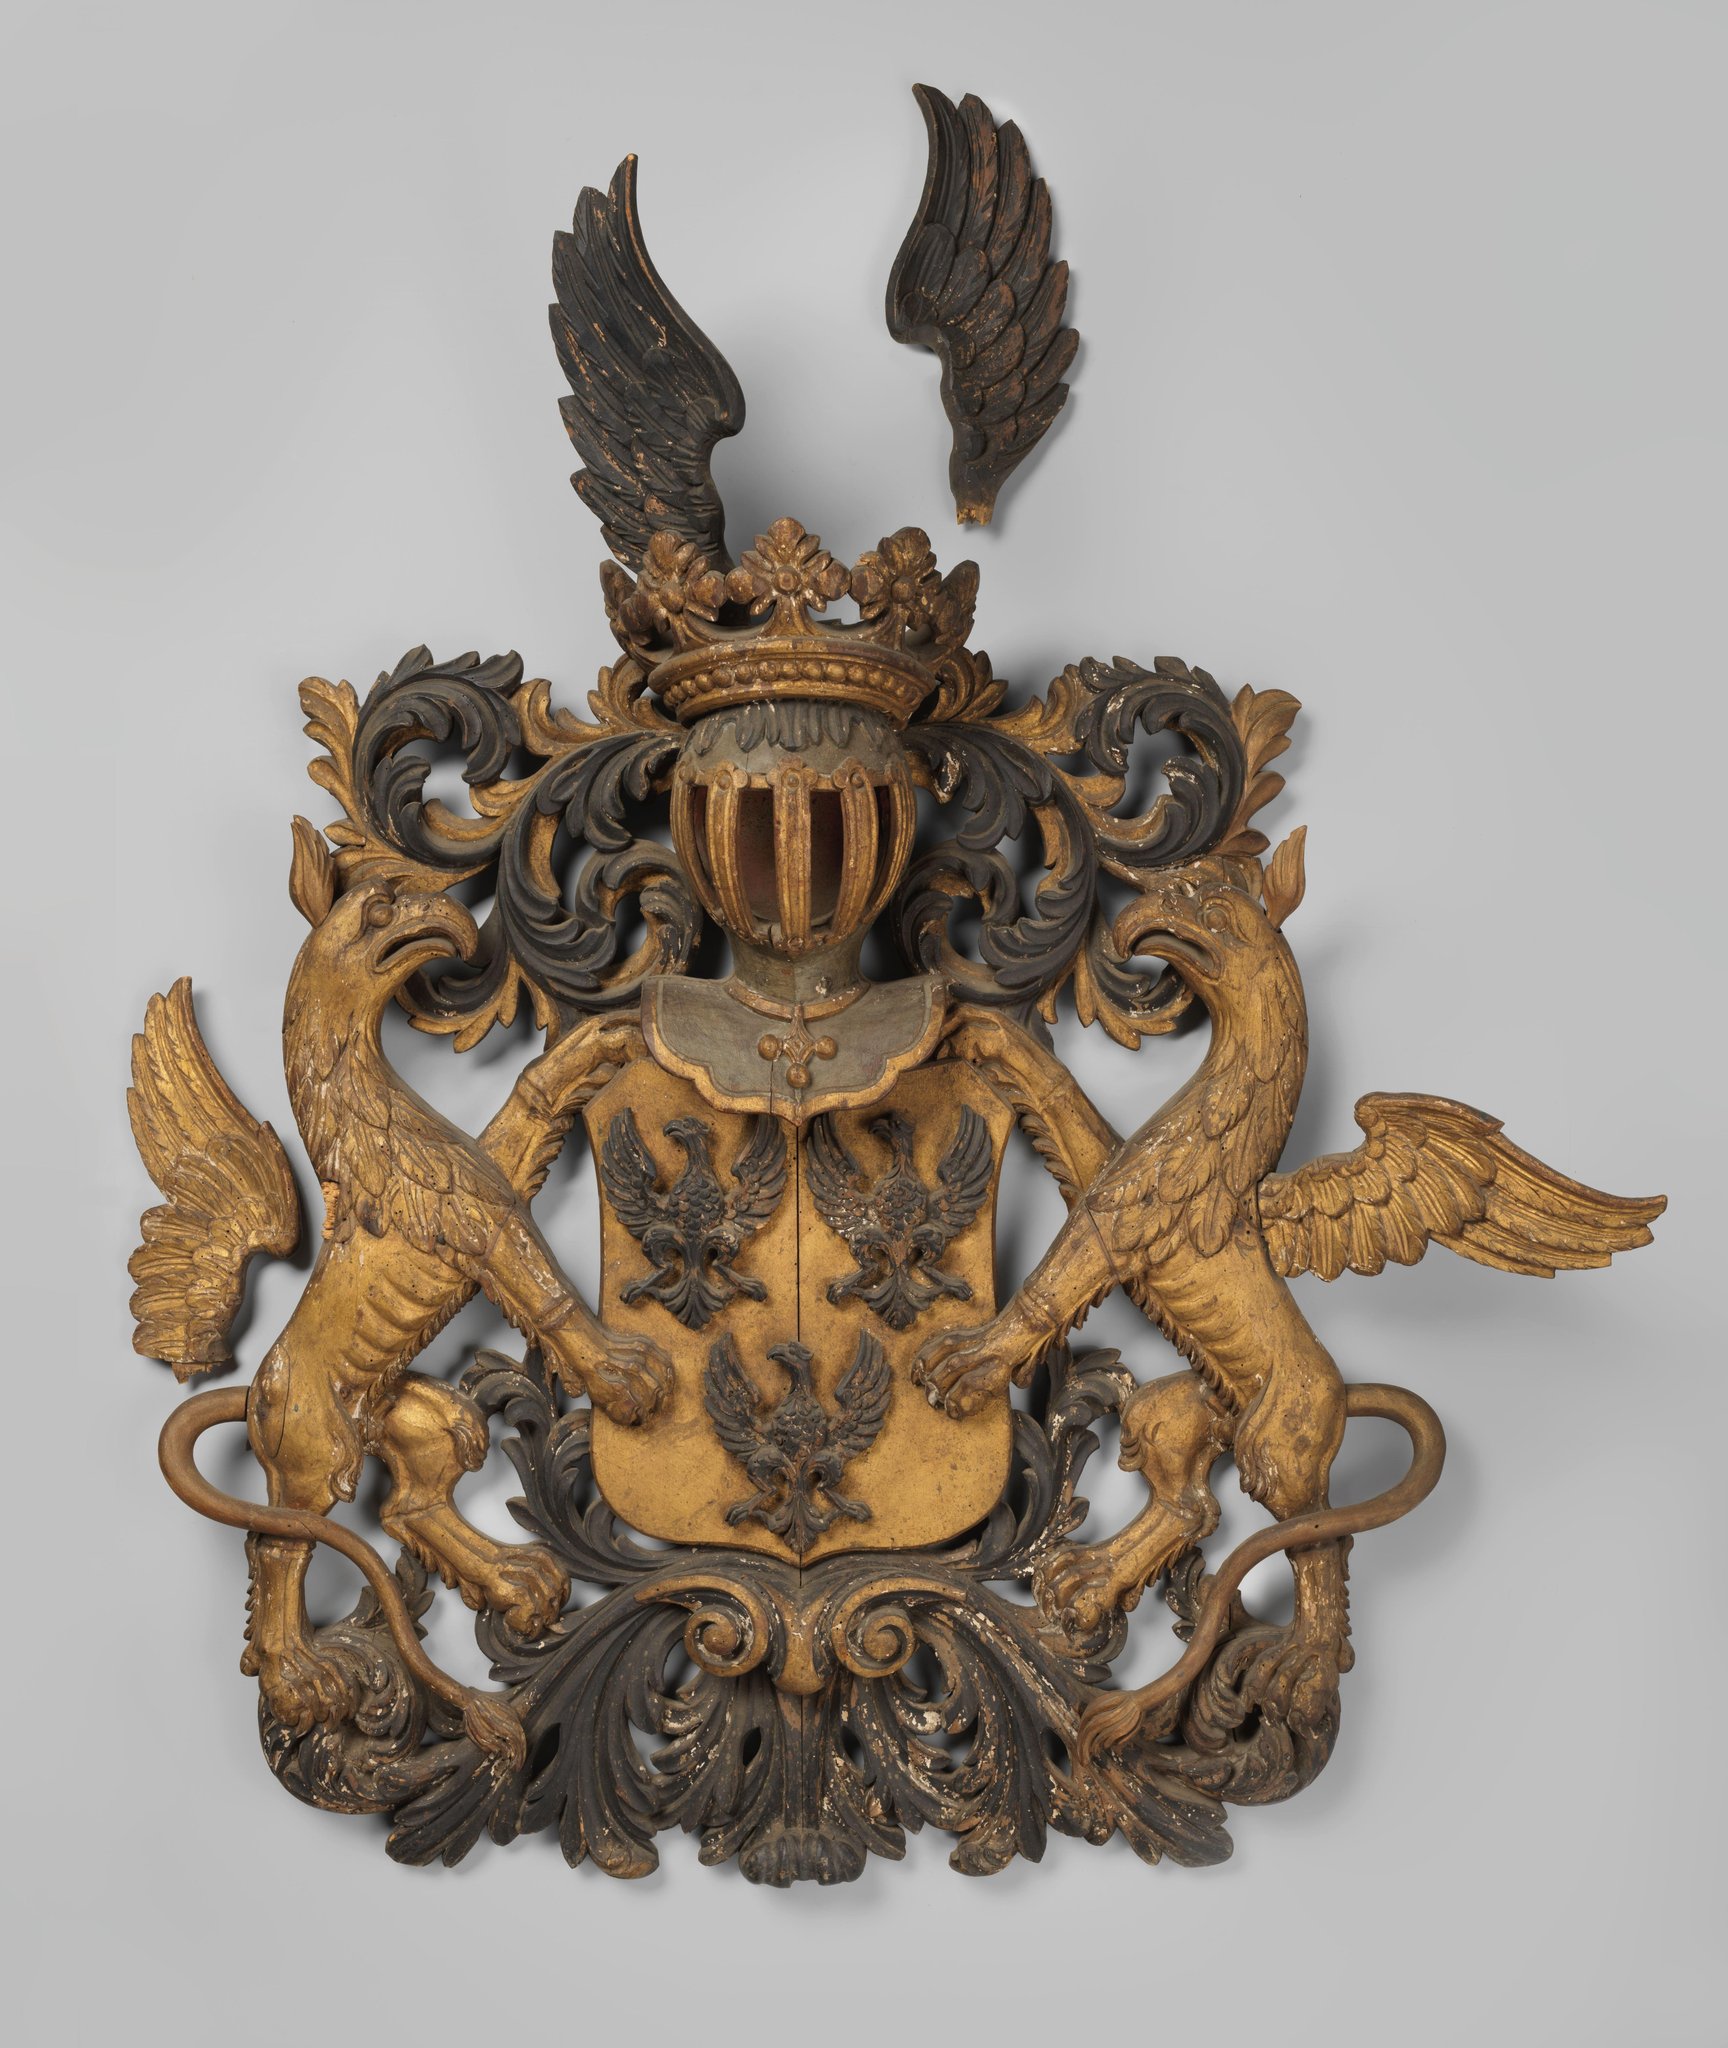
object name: wapenbord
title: Houten wapenbord met in het wapen drie adelaars, vermoedelijk van de familie van Echten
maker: Anonymous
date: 1650-1800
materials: wood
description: Houten gepolychromeerd wapenbord. het wapen wordt gedekt door een helm en door twee griffioenen gehouden. Het wapen draagt drie zwarte adelaars (twee boven, éen onder). Het helmteken bestaat uit twee zwarte (adelaars)vleugels waarvan de linker is afgebroken. Van de linker griffioen is ook een vleugel afgebroken. De kleuren zijn grotendeels afgesleten.